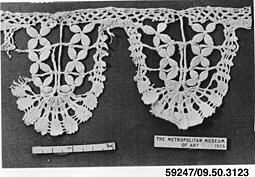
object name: fragment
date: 1601-1700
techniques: lace